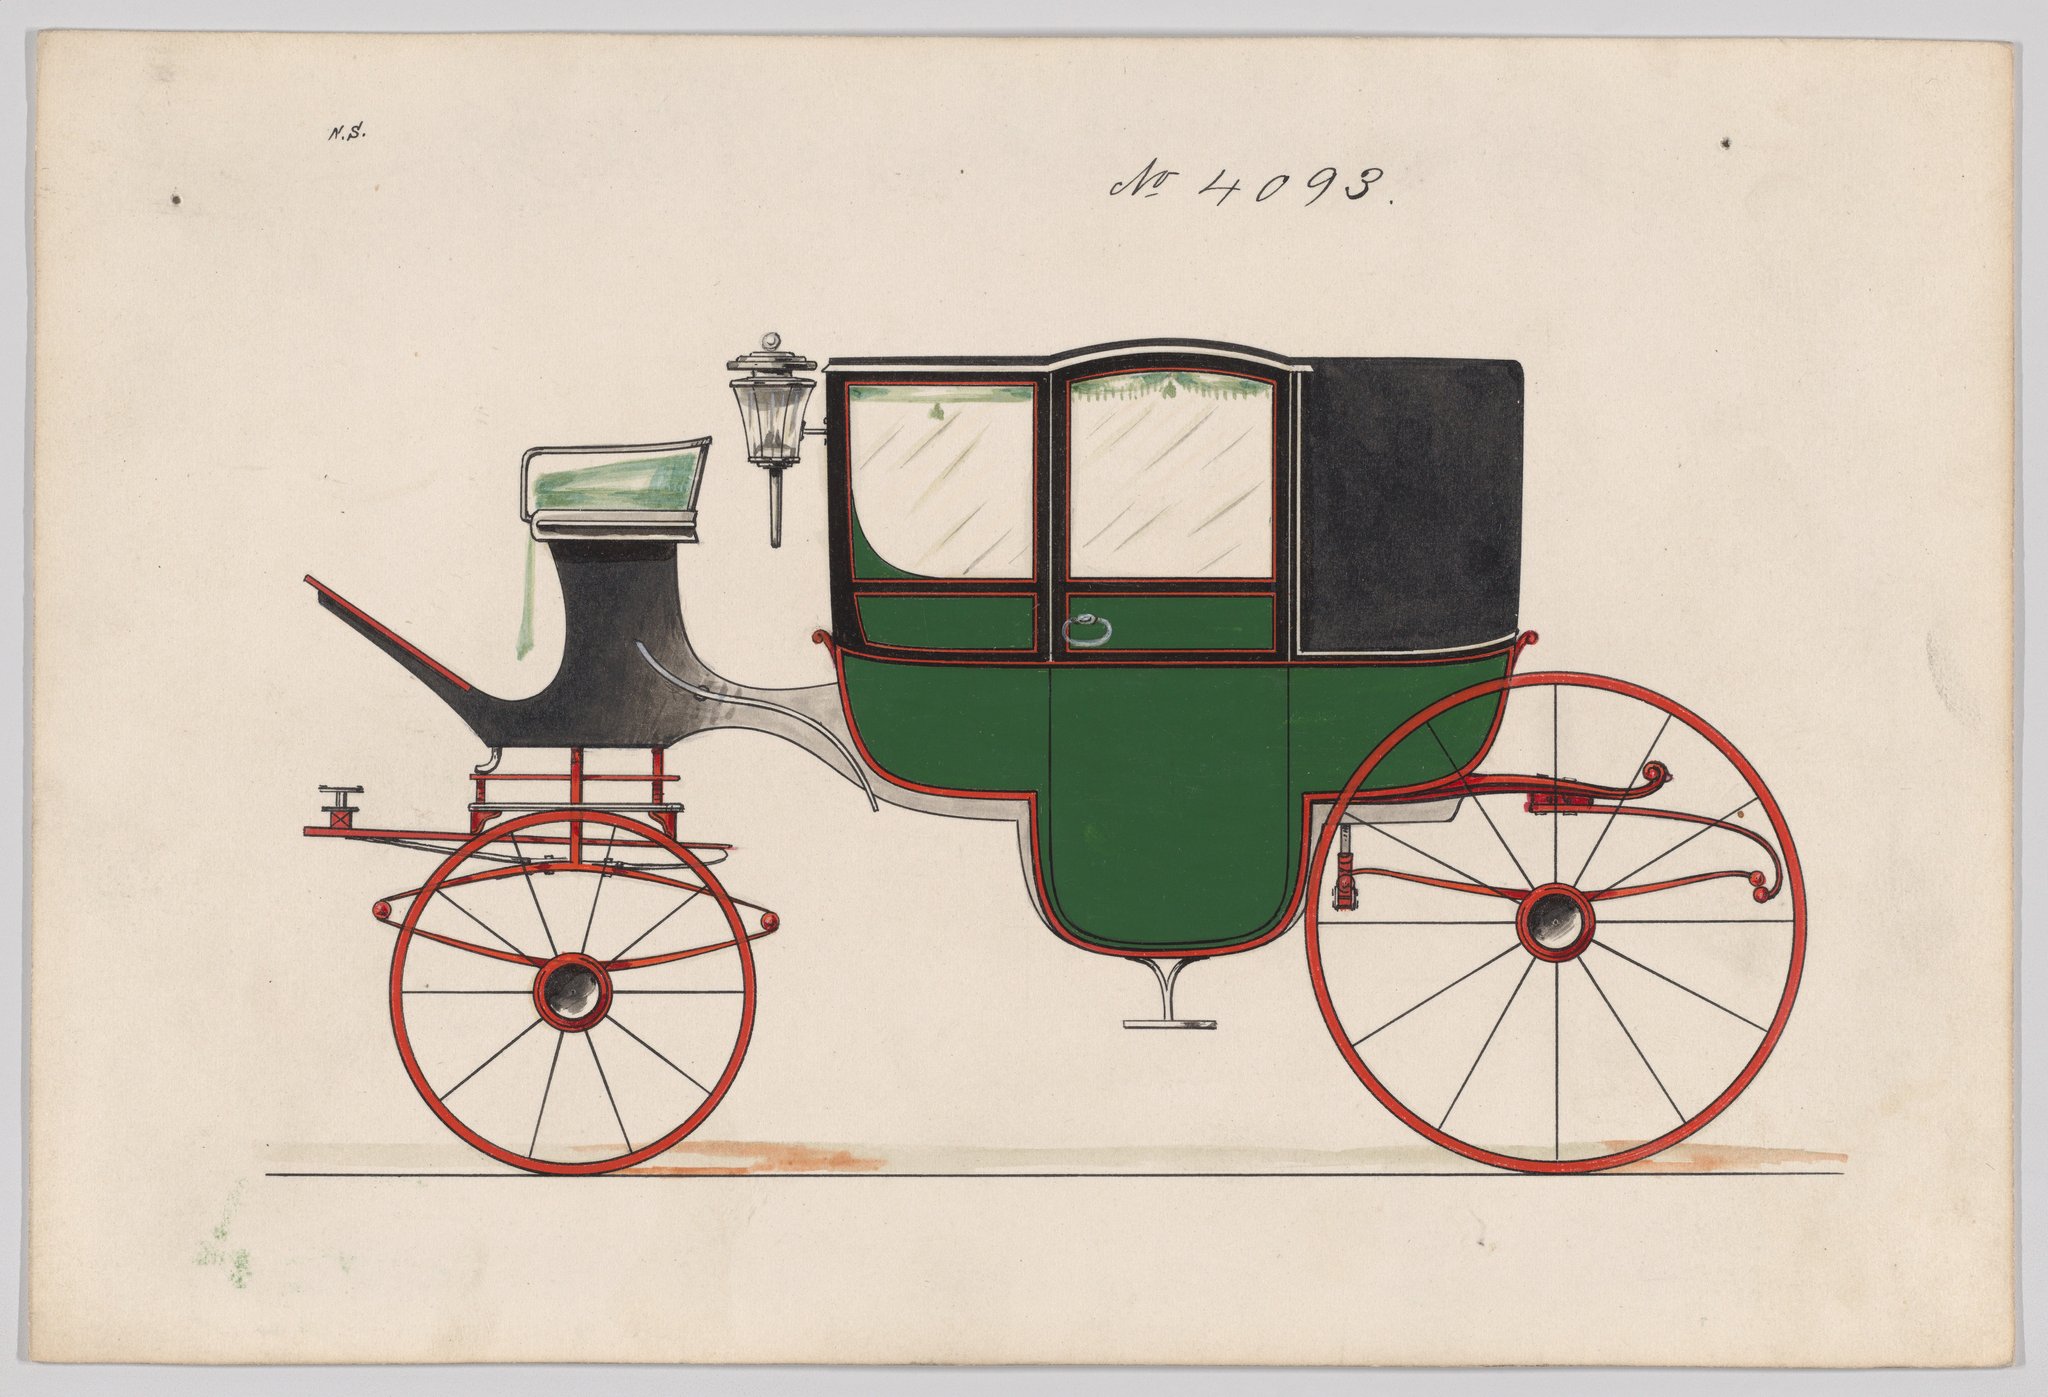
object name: drawing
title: Coach #4093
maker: brewster & co.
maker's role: manufacturer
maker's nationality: american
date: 1890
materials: gouache, gum arabic, ink, watercolor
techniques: pen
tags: carriages